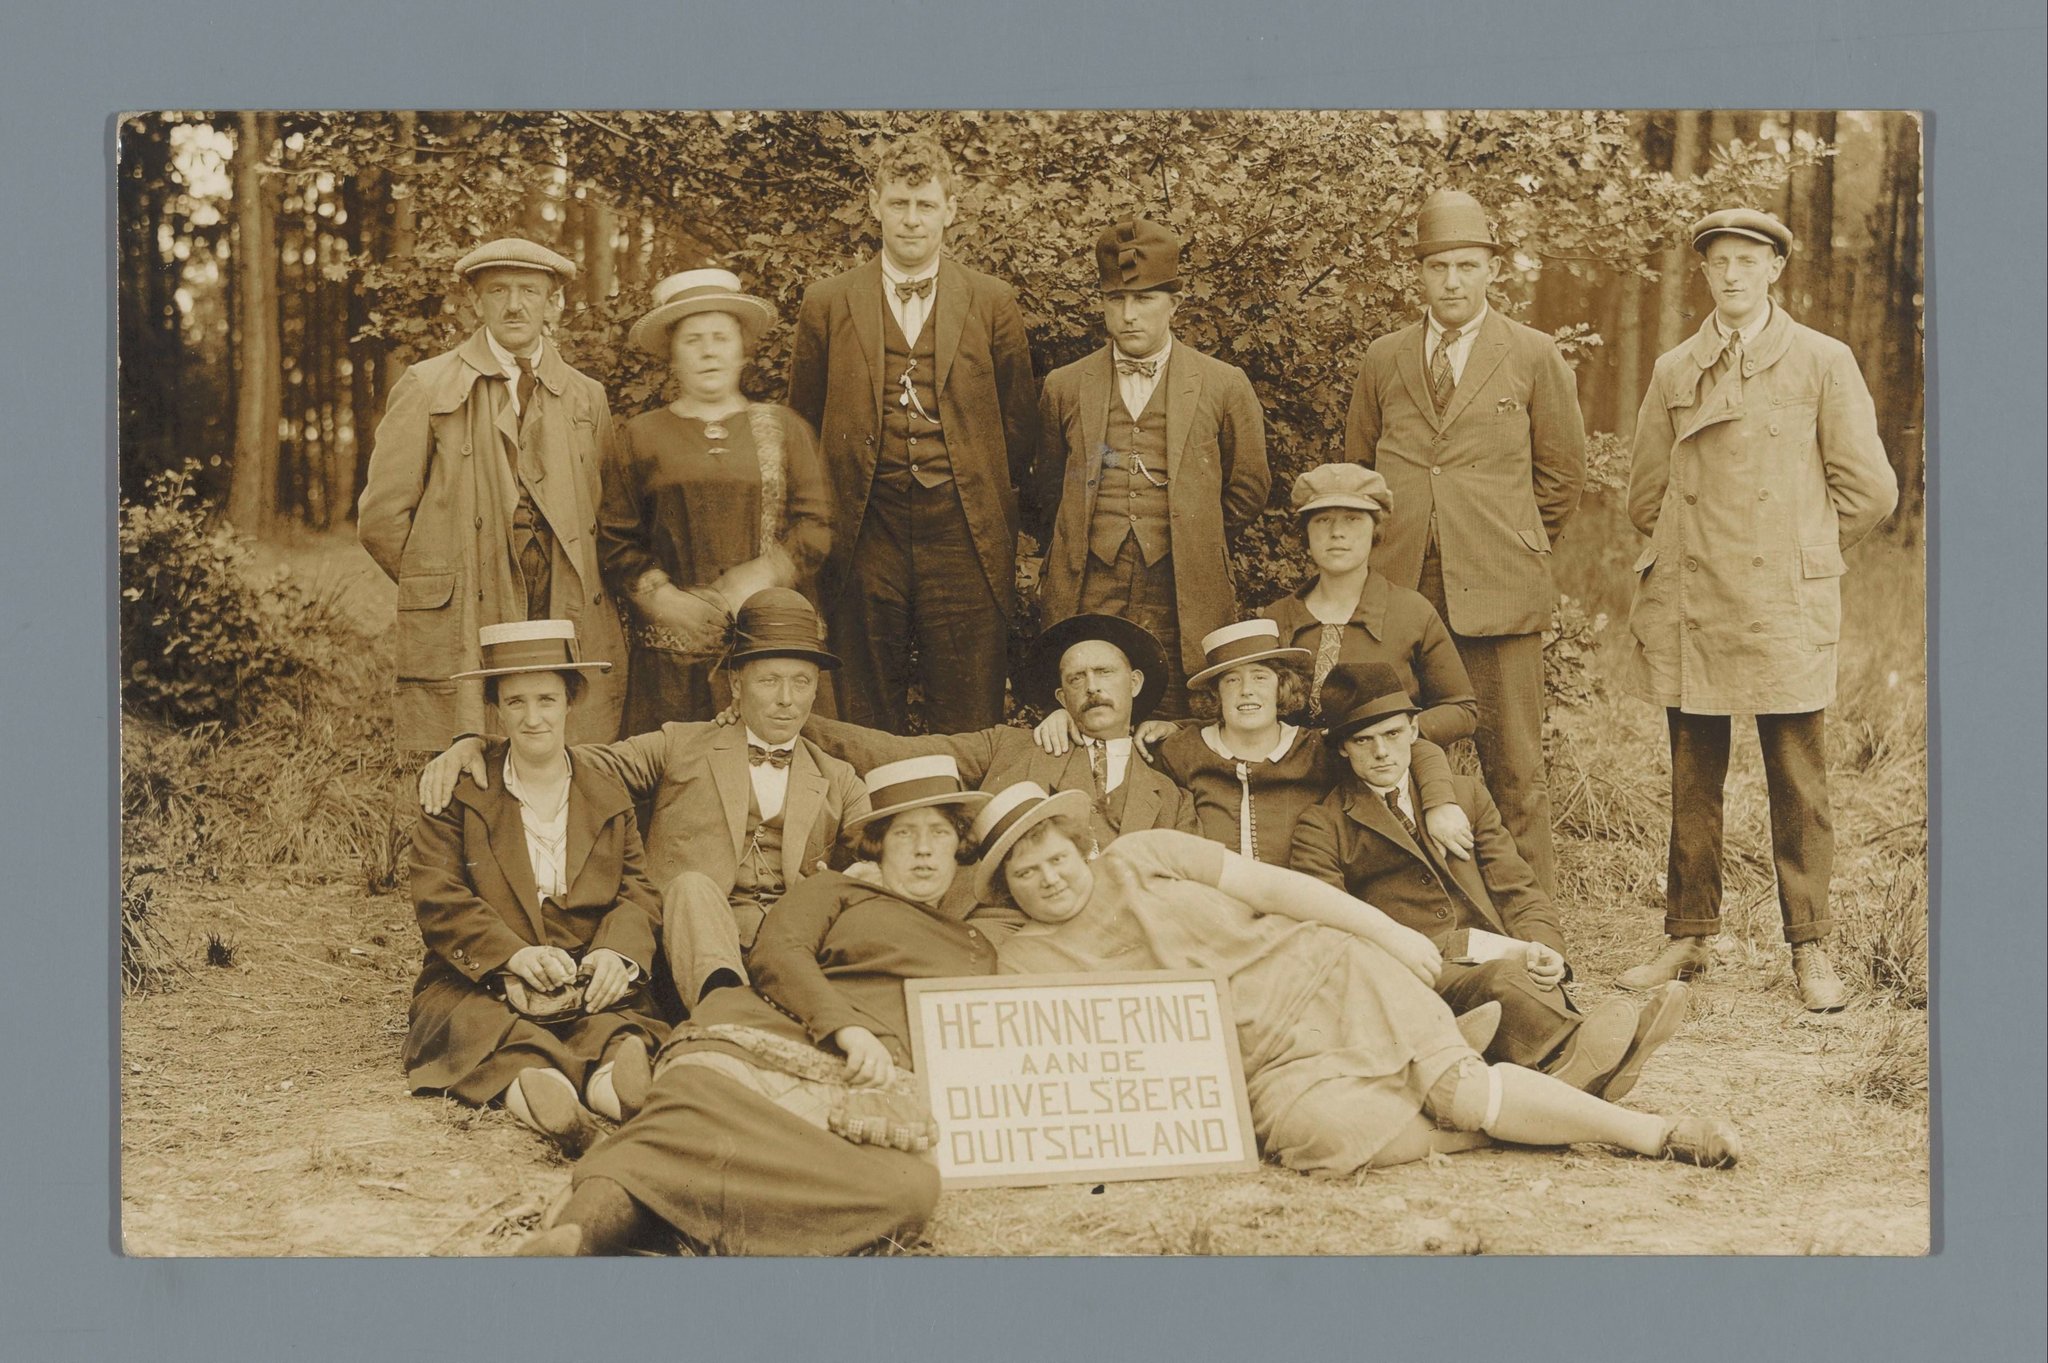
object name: photograph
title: Groepsportret van een onbekend gezelschap op de Duivelsberg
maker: Anonymous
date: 1900-1907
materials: photographic support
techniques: gelatin silver print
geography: duivelsberg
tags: anonymous historical persons portrayed in a group, in a group-portrait